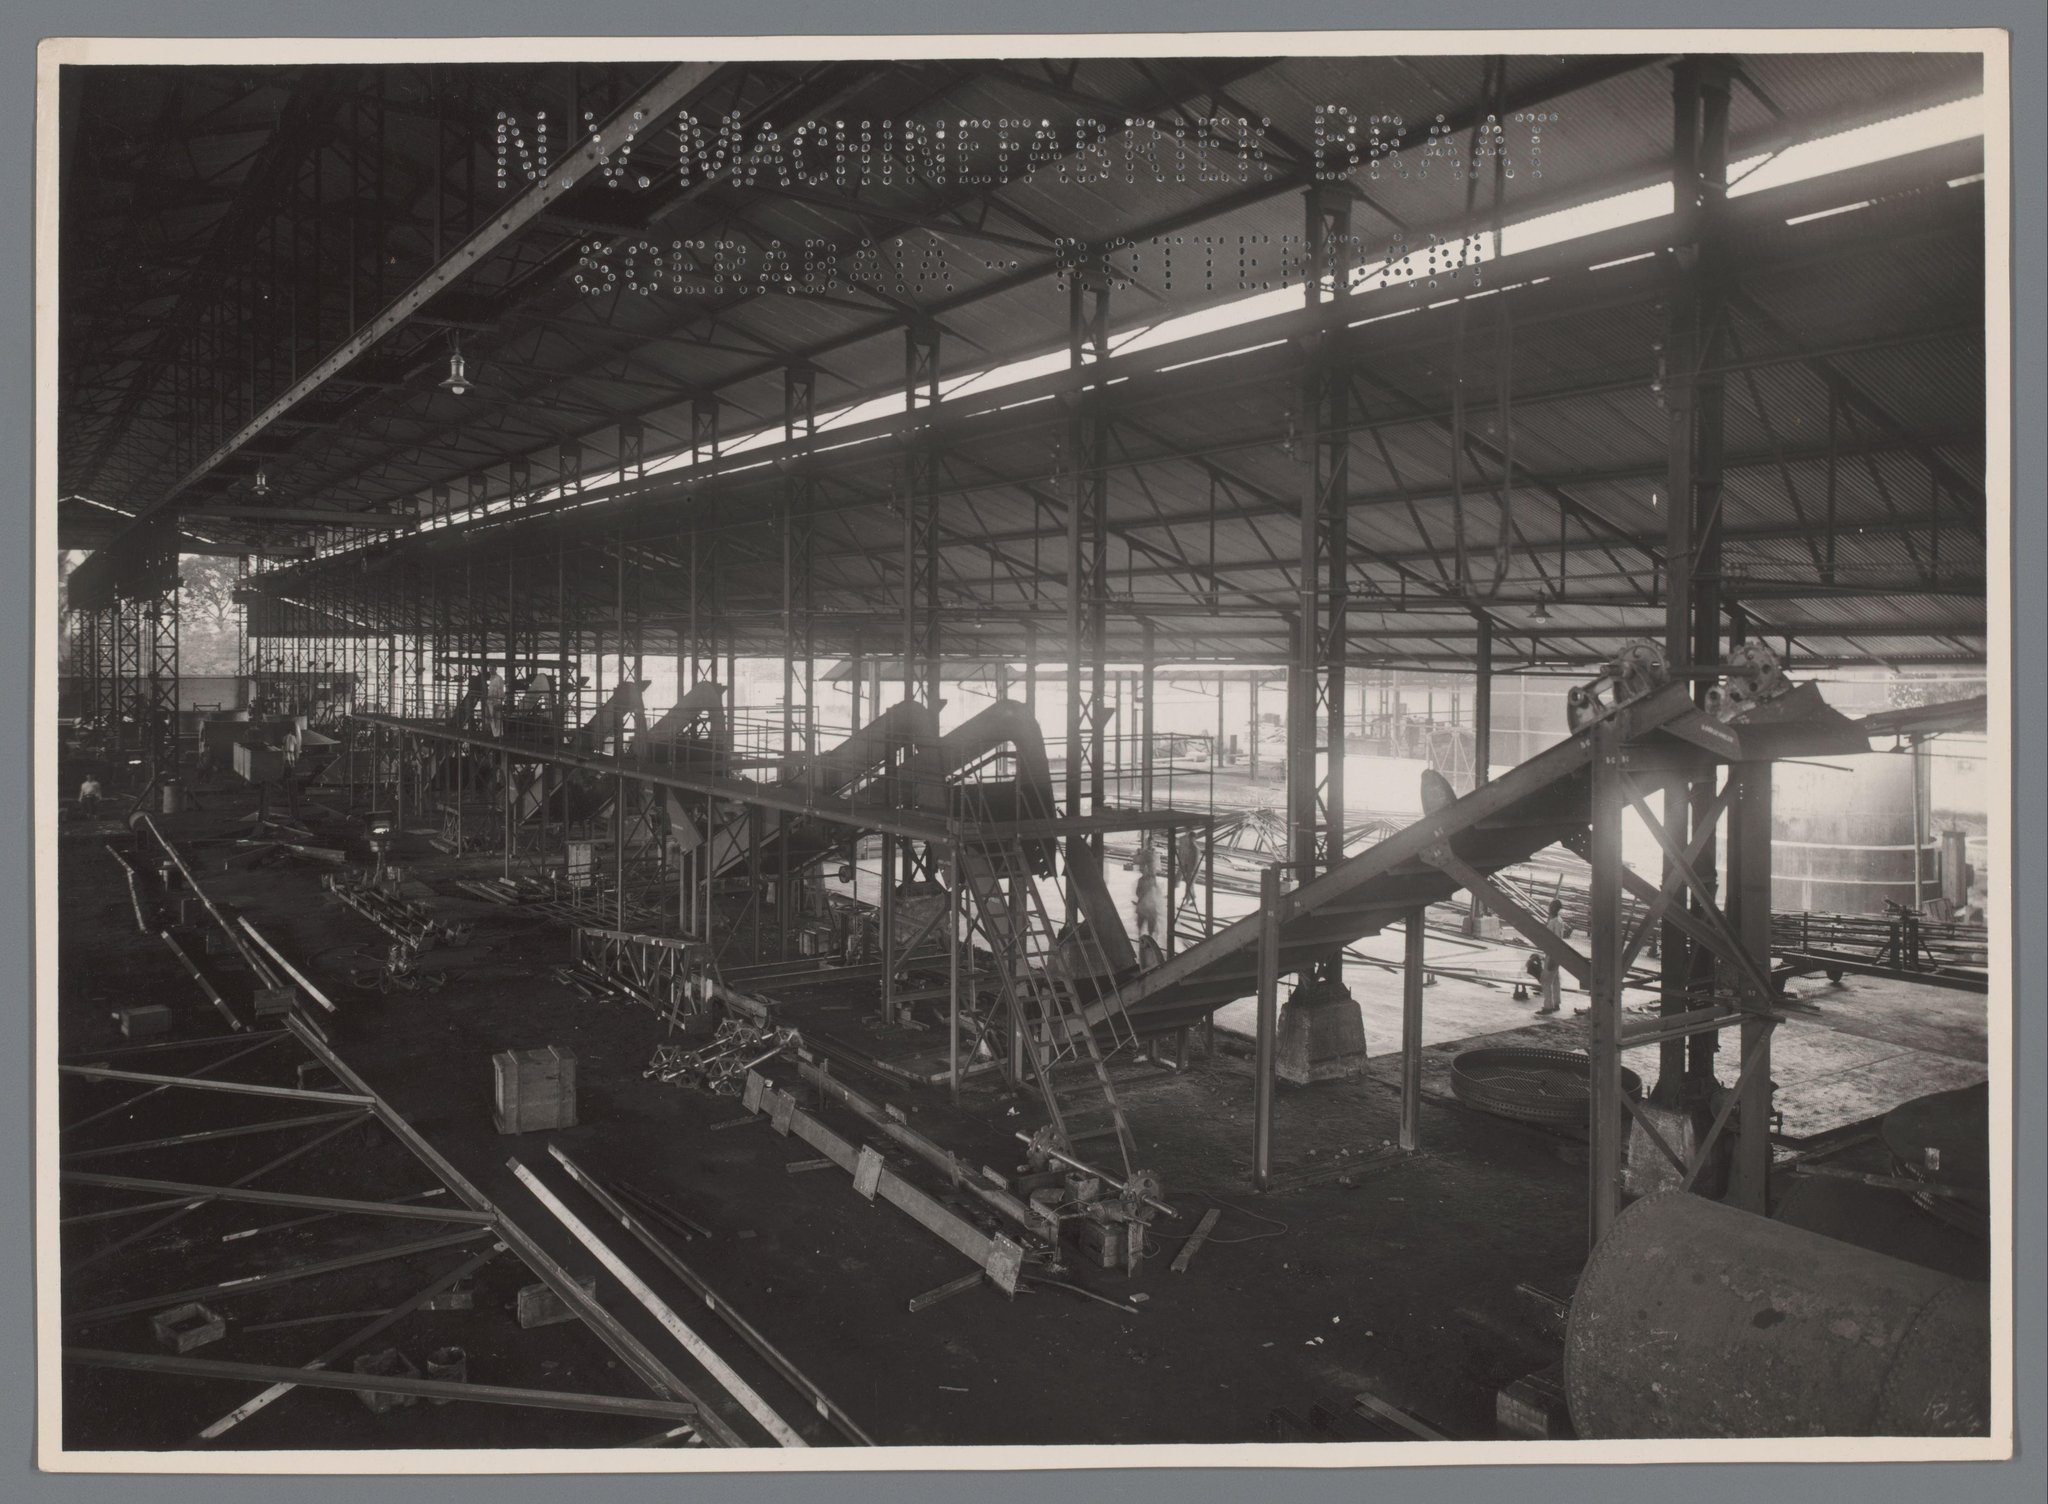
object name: photograph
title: Transportbanden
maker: Anonymous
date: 1925-1935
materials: photographic support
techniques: gelatin silver print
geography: surabaya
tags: colonial system, factory-interior, machine shop, machines; parts of machines; tools and appliances, java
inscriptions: company name: ‘N.V. Machinefabriek Braat / Soerabaia – Rotterdam’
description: Transportbanden in serieproductie, ca. 1930. Onderdeel van de multomap met foto's van machines van de N.V. Machinefabriek Braat te Soerabaja, Soekaboemi en Jogyakarta, uit de periode 1908-1942.